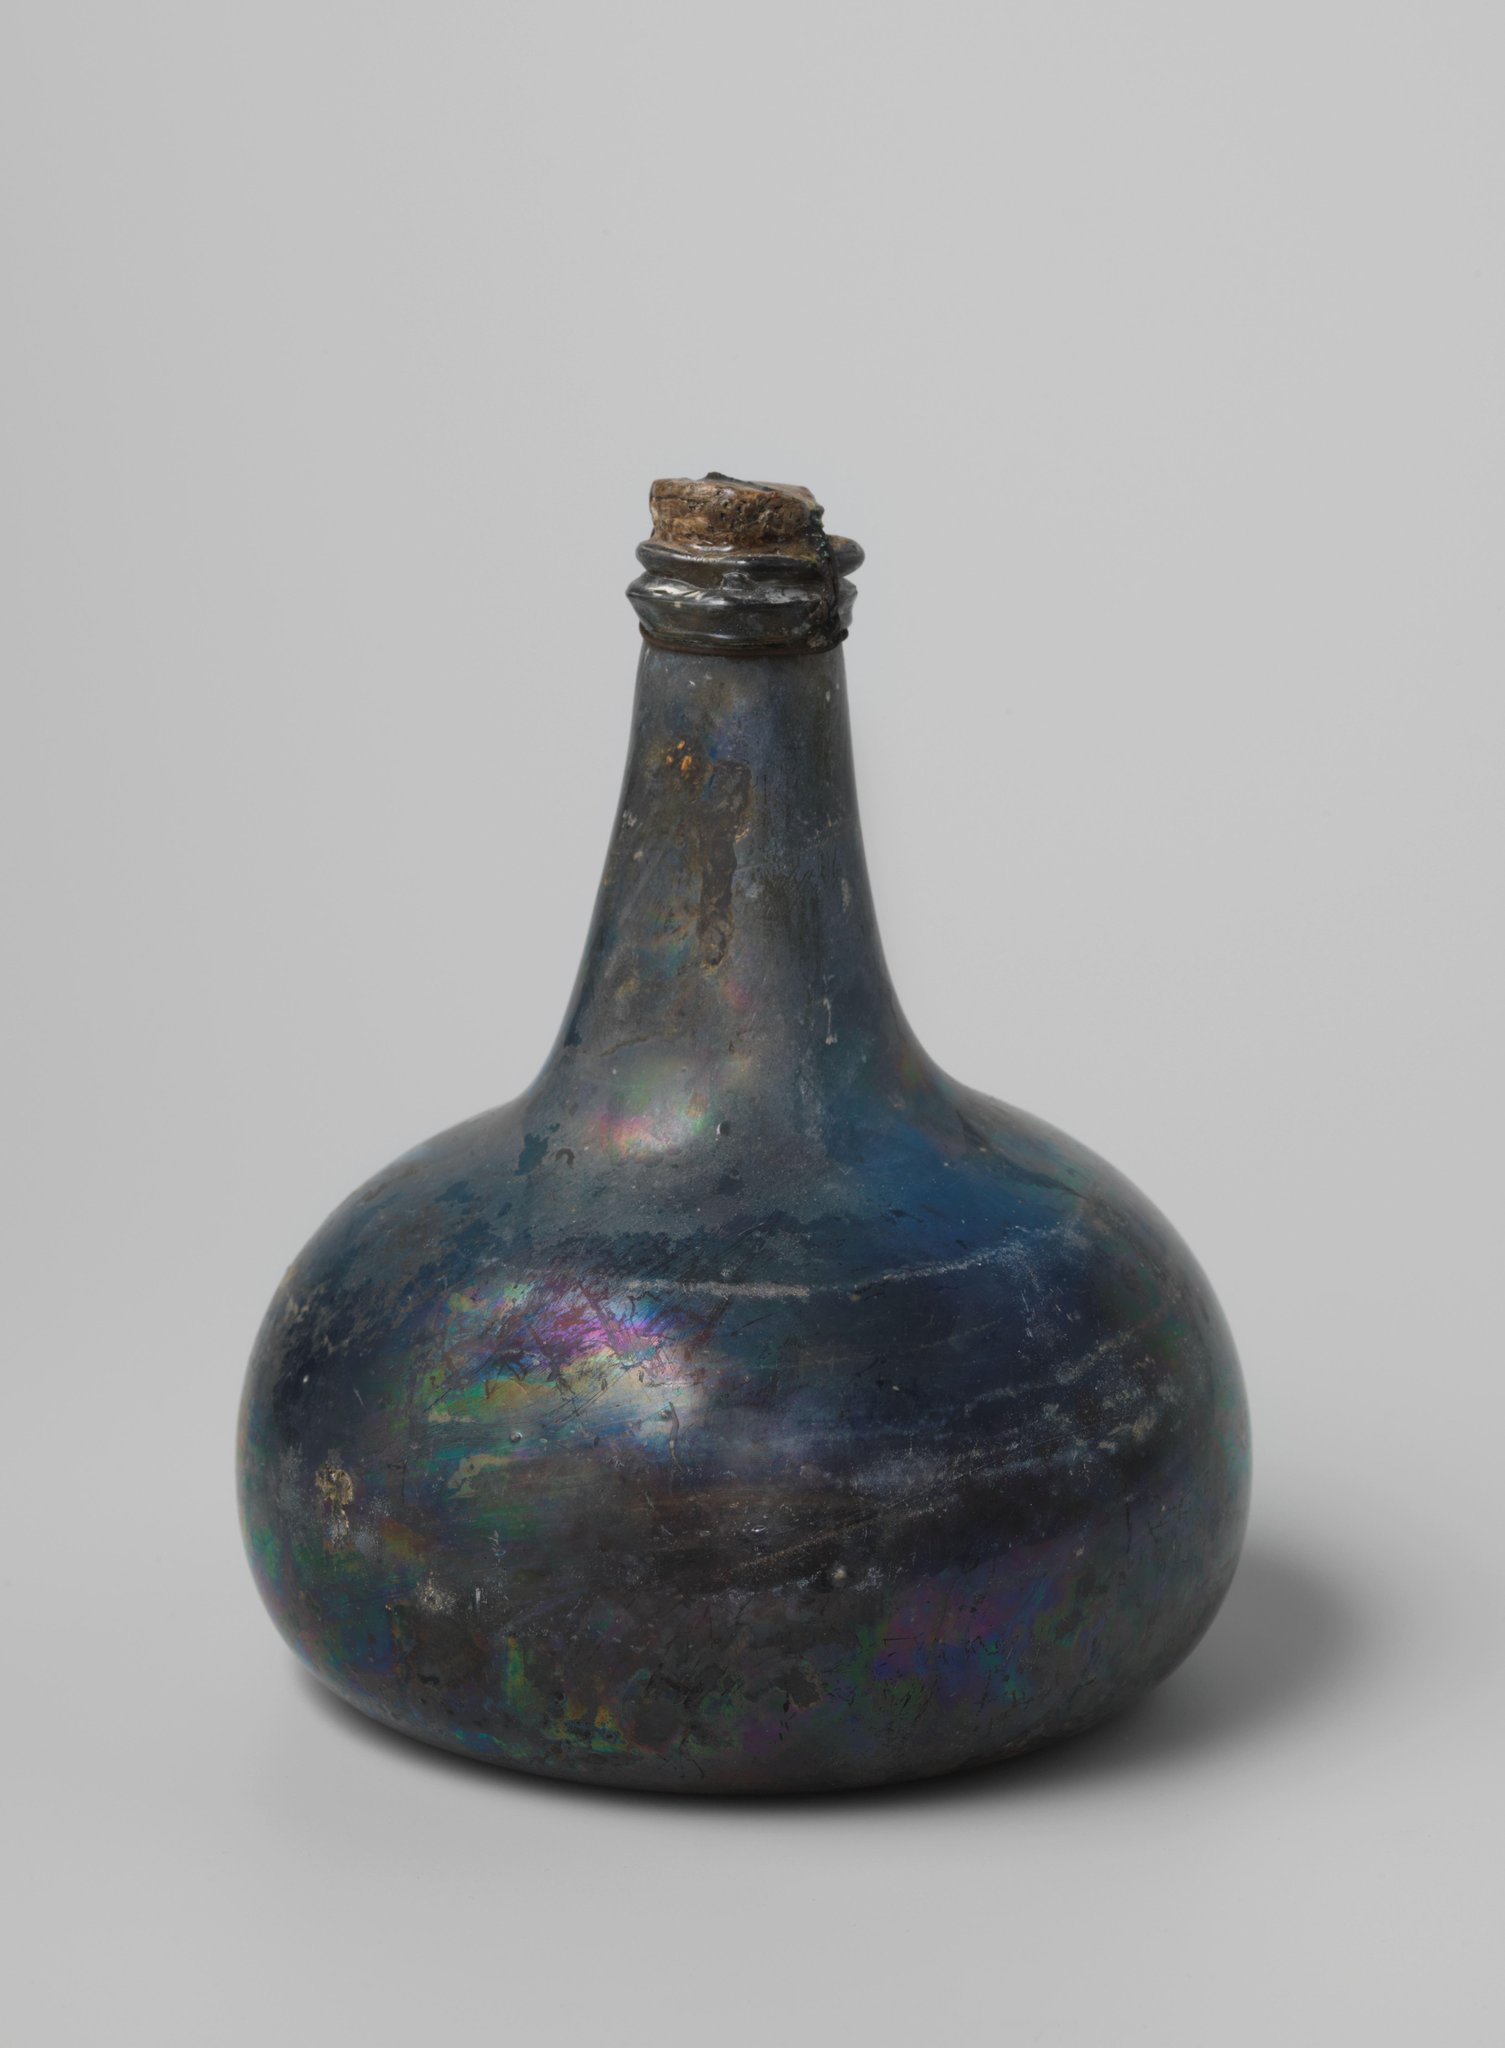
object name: wine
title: Wijnfles met wijn uit het wrak van de Oost-Indiëvaarder 't Vliegend Hart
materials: glass, liquid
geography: netherlands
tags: 't vliegend hart (schip), verenigde oostindische compagnie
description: Uivormige wijnfles van groen glas gevuld met rode (port)wijn en afgesloten met kurk en draad die de kurk op zijn plaats moest houden.